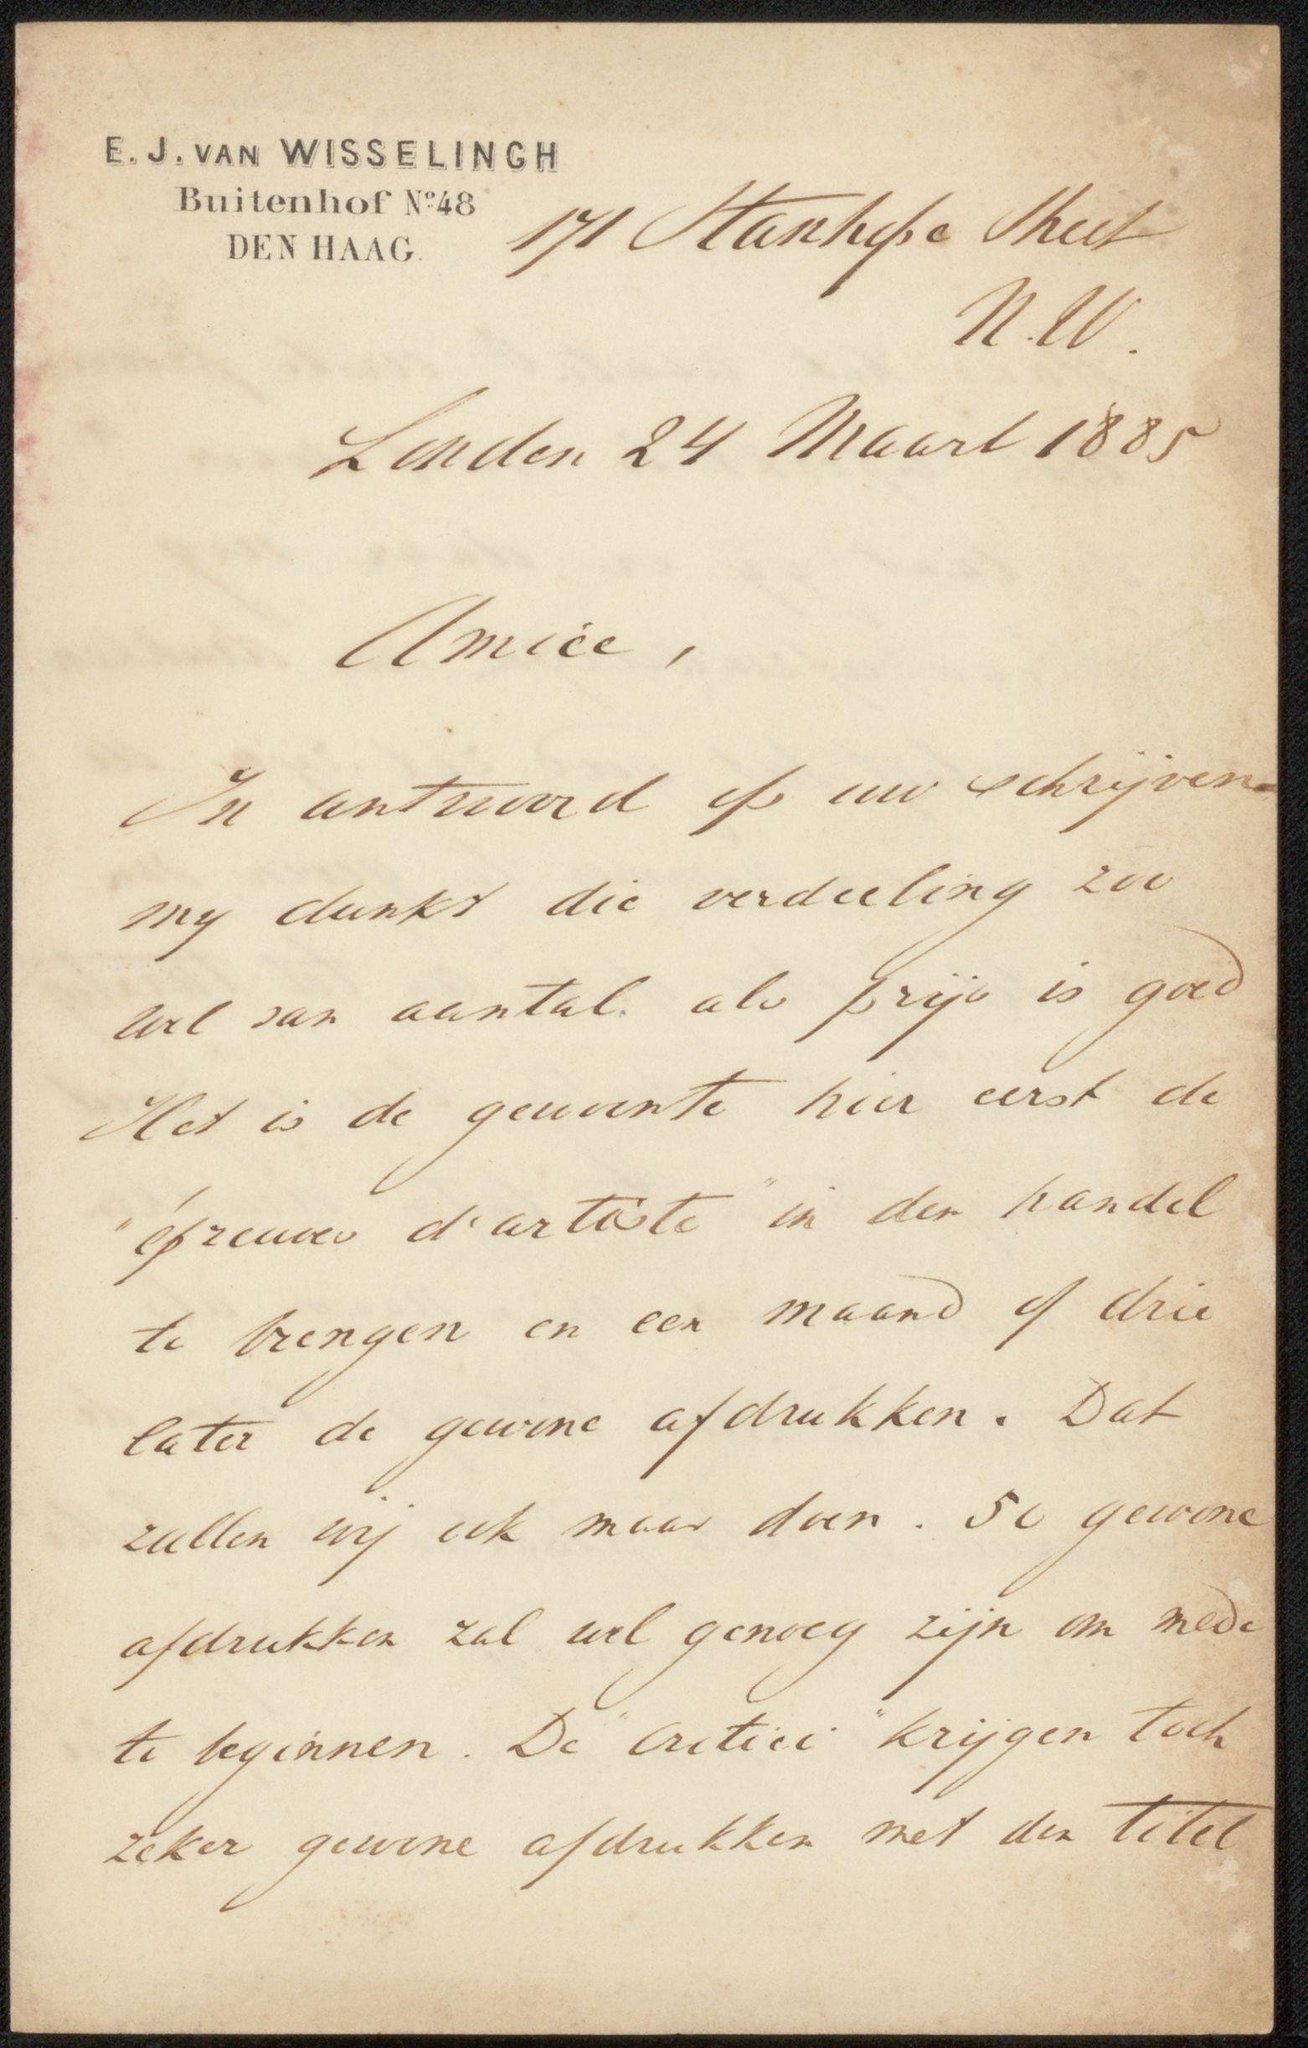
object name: letter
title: Brief aan Philip Zilcken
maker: elbert jan van wisselingh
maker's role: kunsthandelaar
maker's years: 1848-1912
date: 1885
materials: ink, paper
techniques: pen, printing, writing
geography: london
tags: painter, draughtsman, philip zilcken, art trade, art shop, the graphic arts, exhibition ~ art, the hague, paris, glasgow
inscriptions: collector's mark: ‘RPK’, watermark